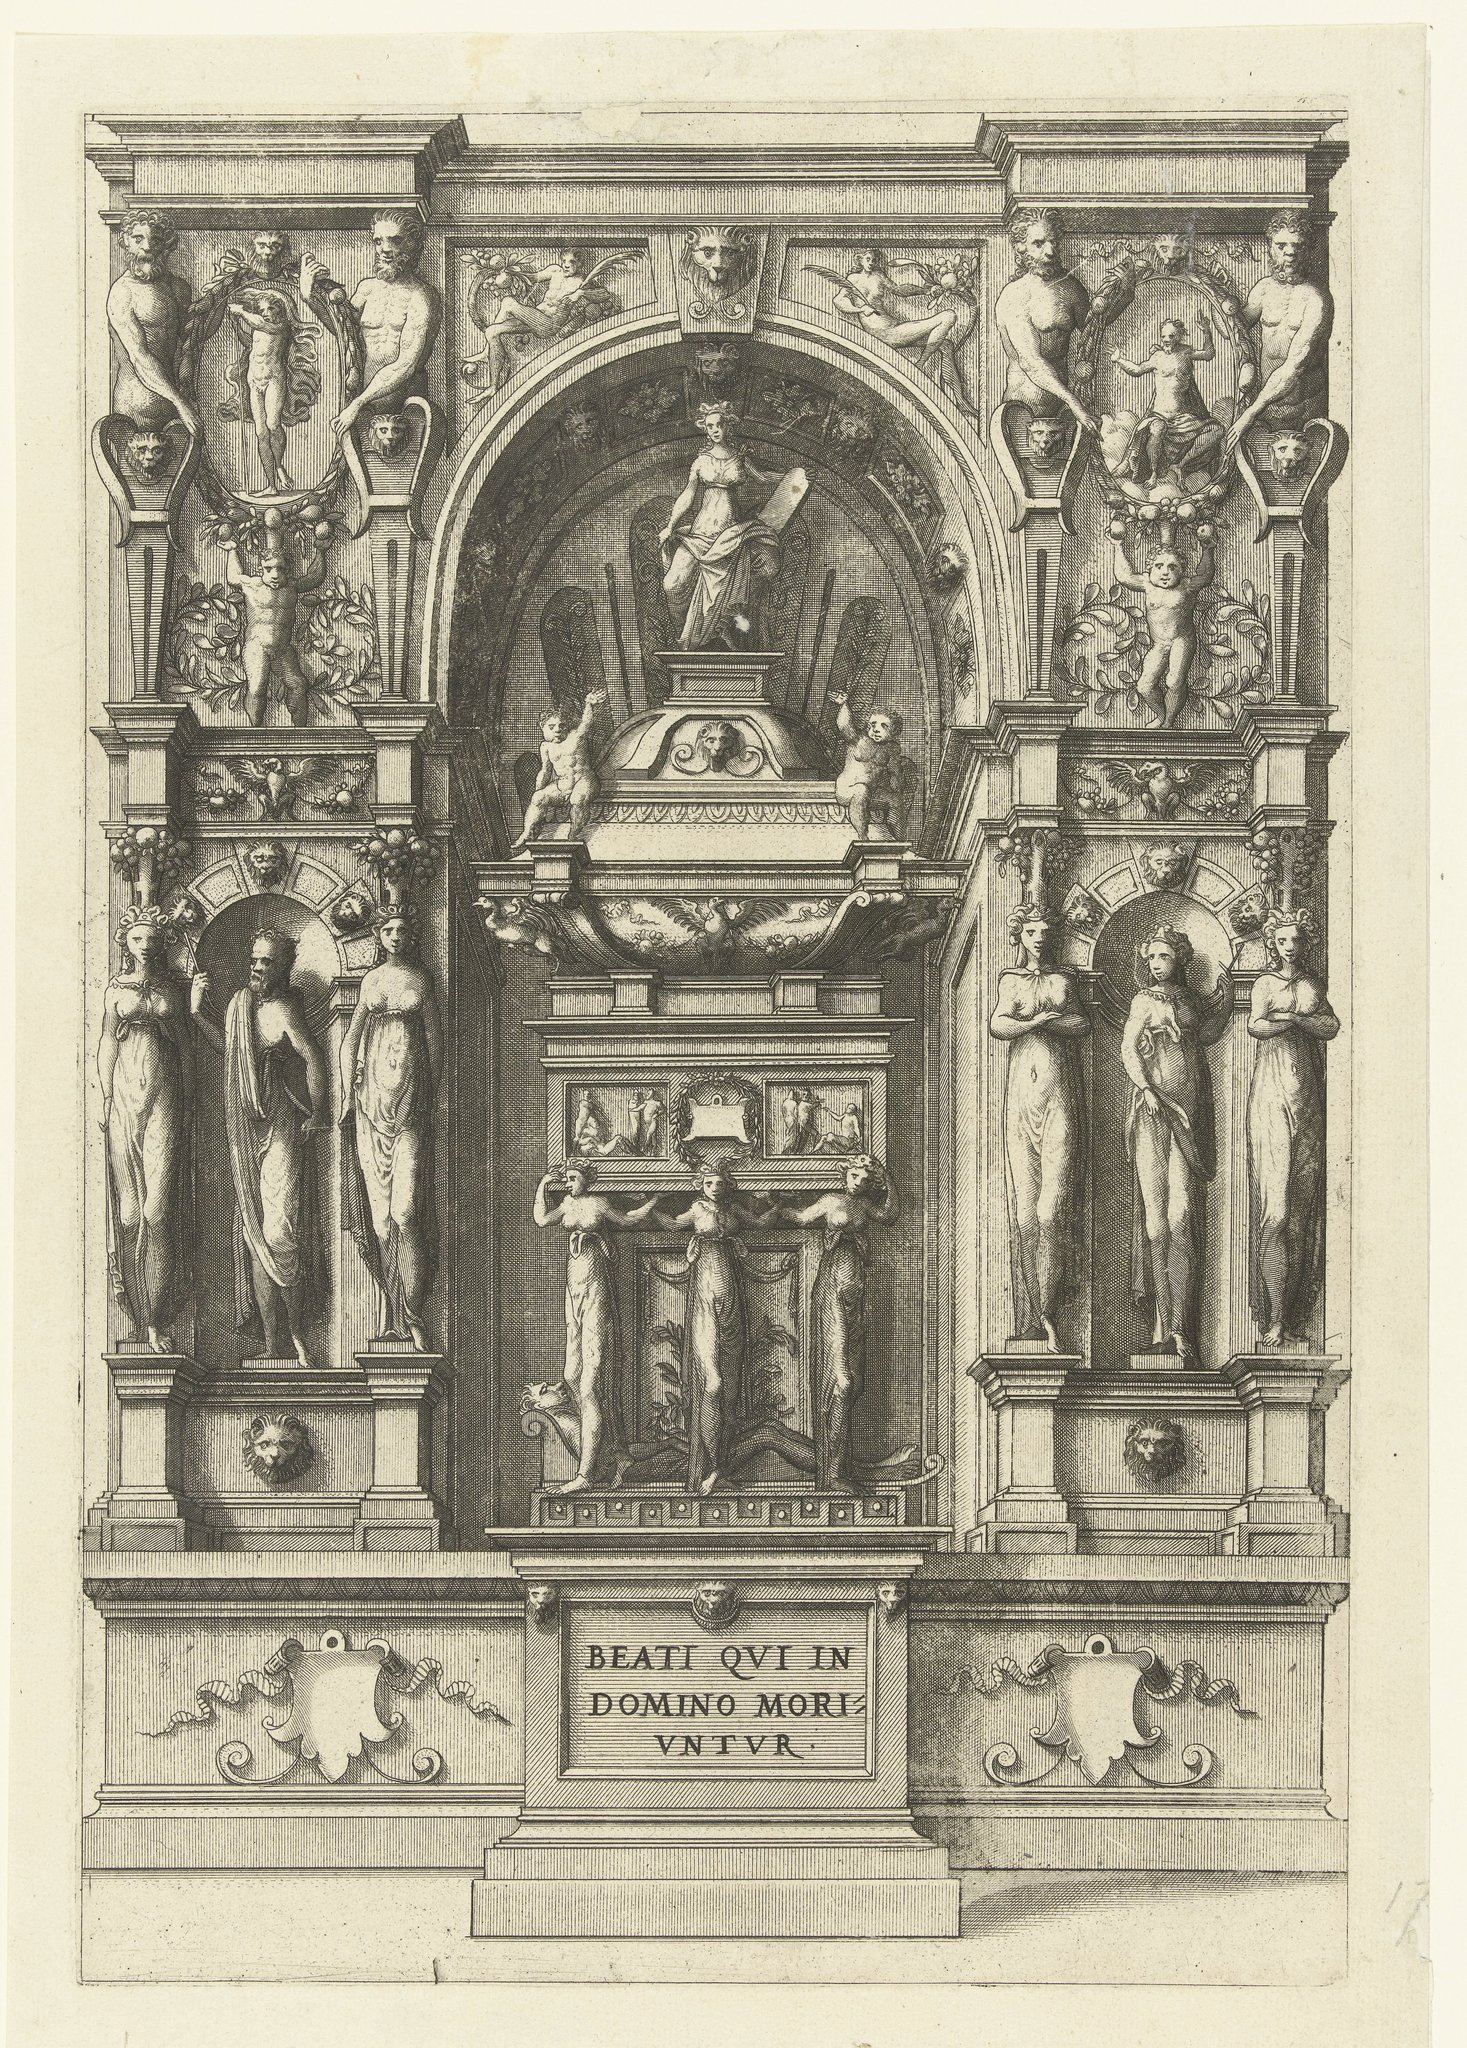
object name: ornament print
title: Vlakdecoraties en grafmonumenten / Veelderleij niewe inventien (...)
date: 1557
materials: paper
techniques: etching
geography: netherlands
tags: grave, tomb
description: Op een sokkel met een vooruitspringende middenrisaliet staat een dubbel gelede wand, gedecoreerd met figuren en grotesken, ter weerszijden van een nis. In de nis een sarcofaag op een voetstuk, gedragen door drie kariatiden. Op het deksel zit een vrouw met een tablet. Middenonder in cartouche: BEATI QUI IN / DOMINI MORI / UNTUR. Hoort bij serie bestaande uit een titelblad, een tekstblad en 14 bladen met grotesken met rolwerk, saters, guirlandes, trofeeën, dieren en fantasiewezens.